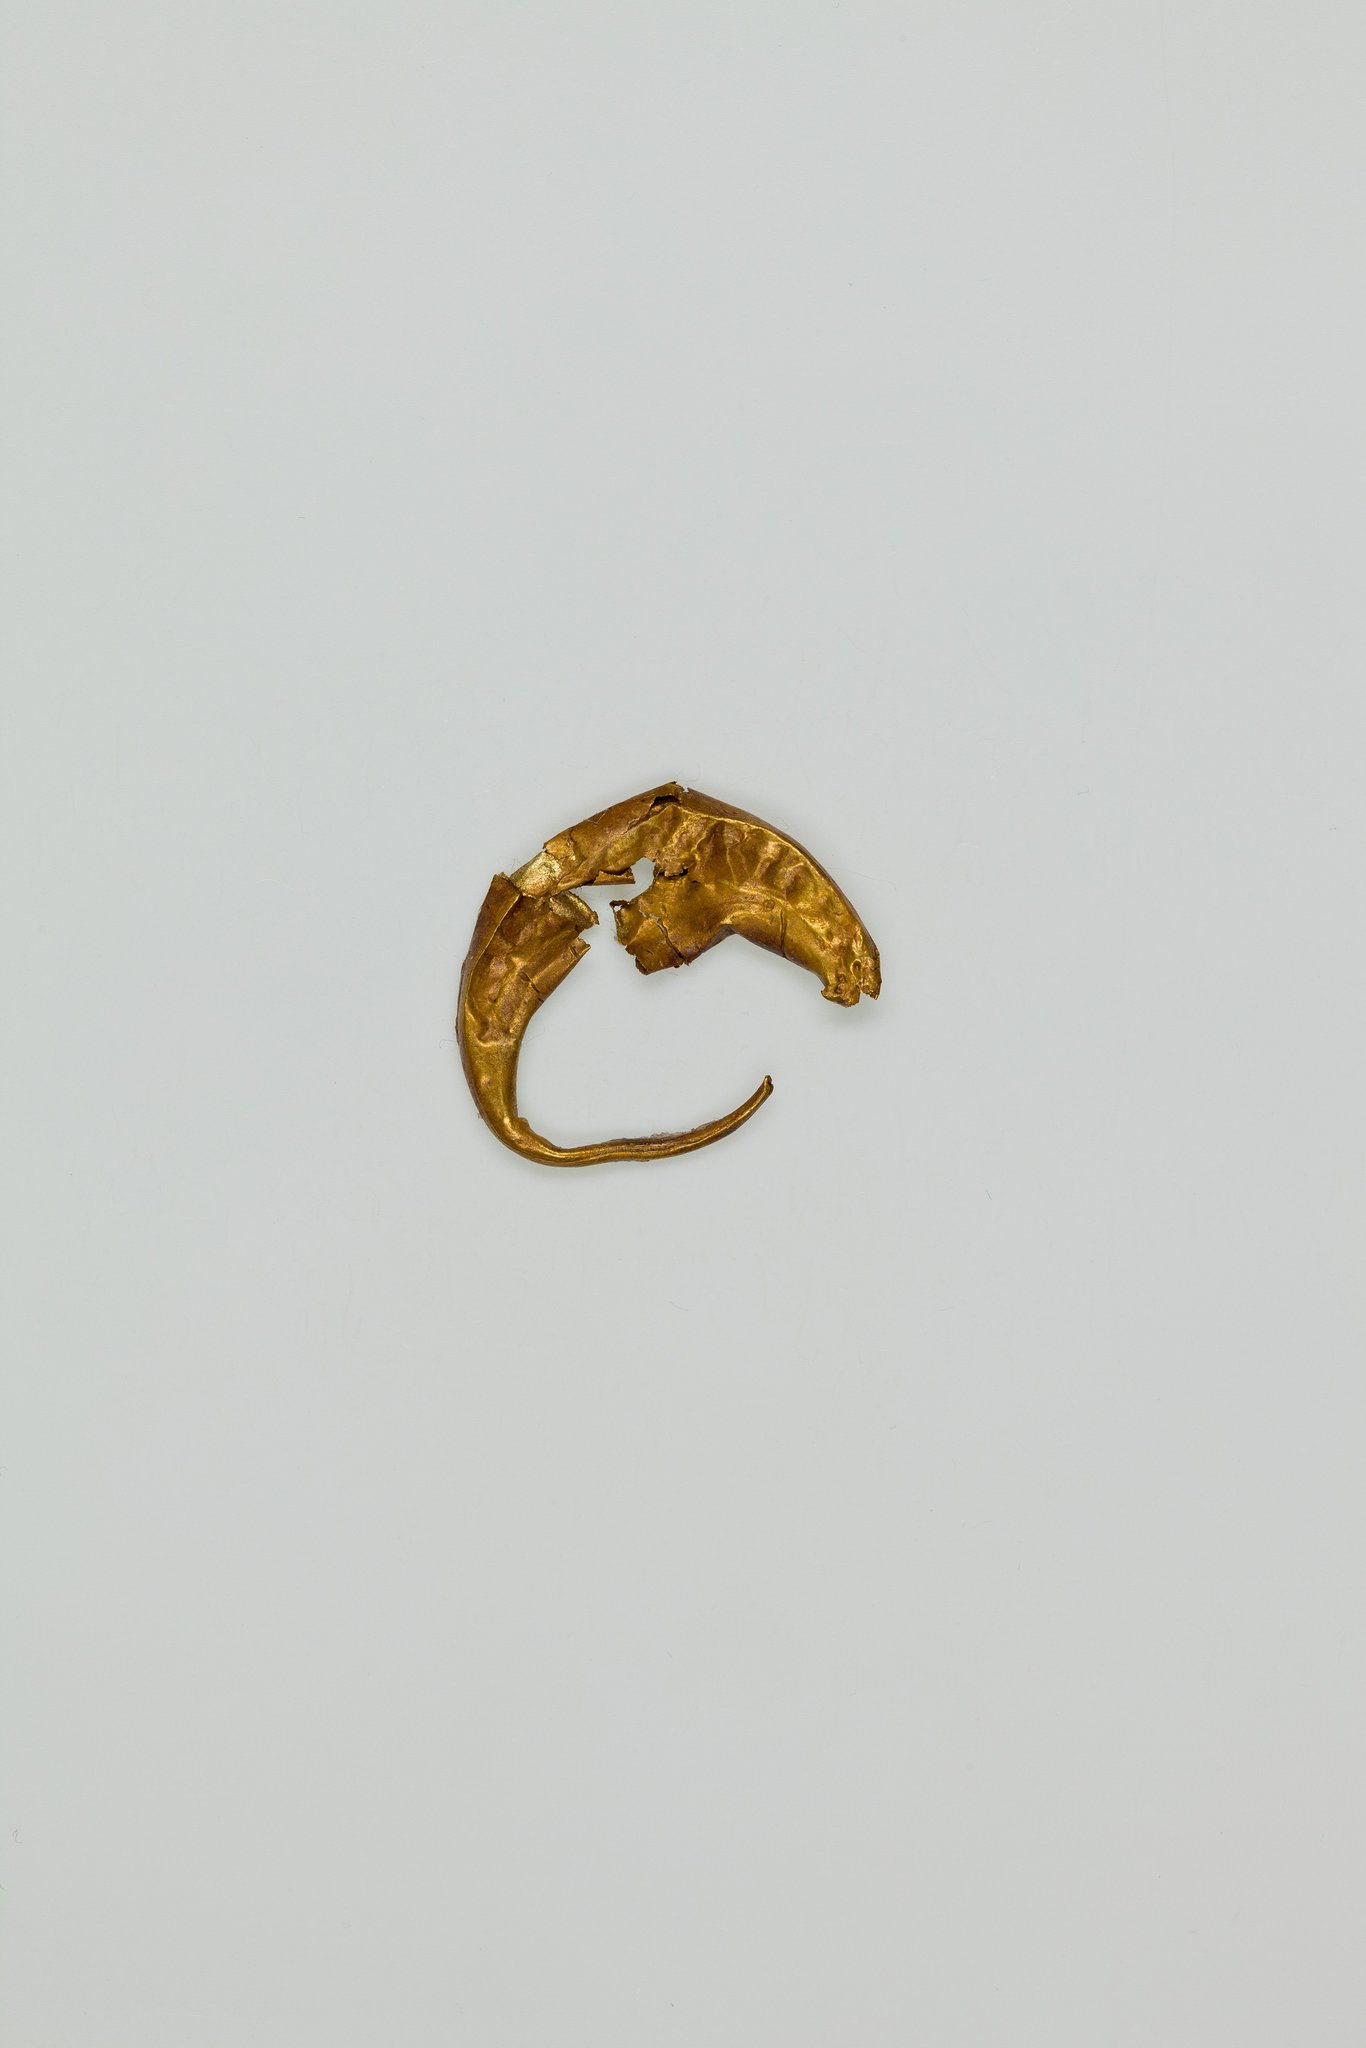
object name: earring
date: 664-380 BCE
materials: gold